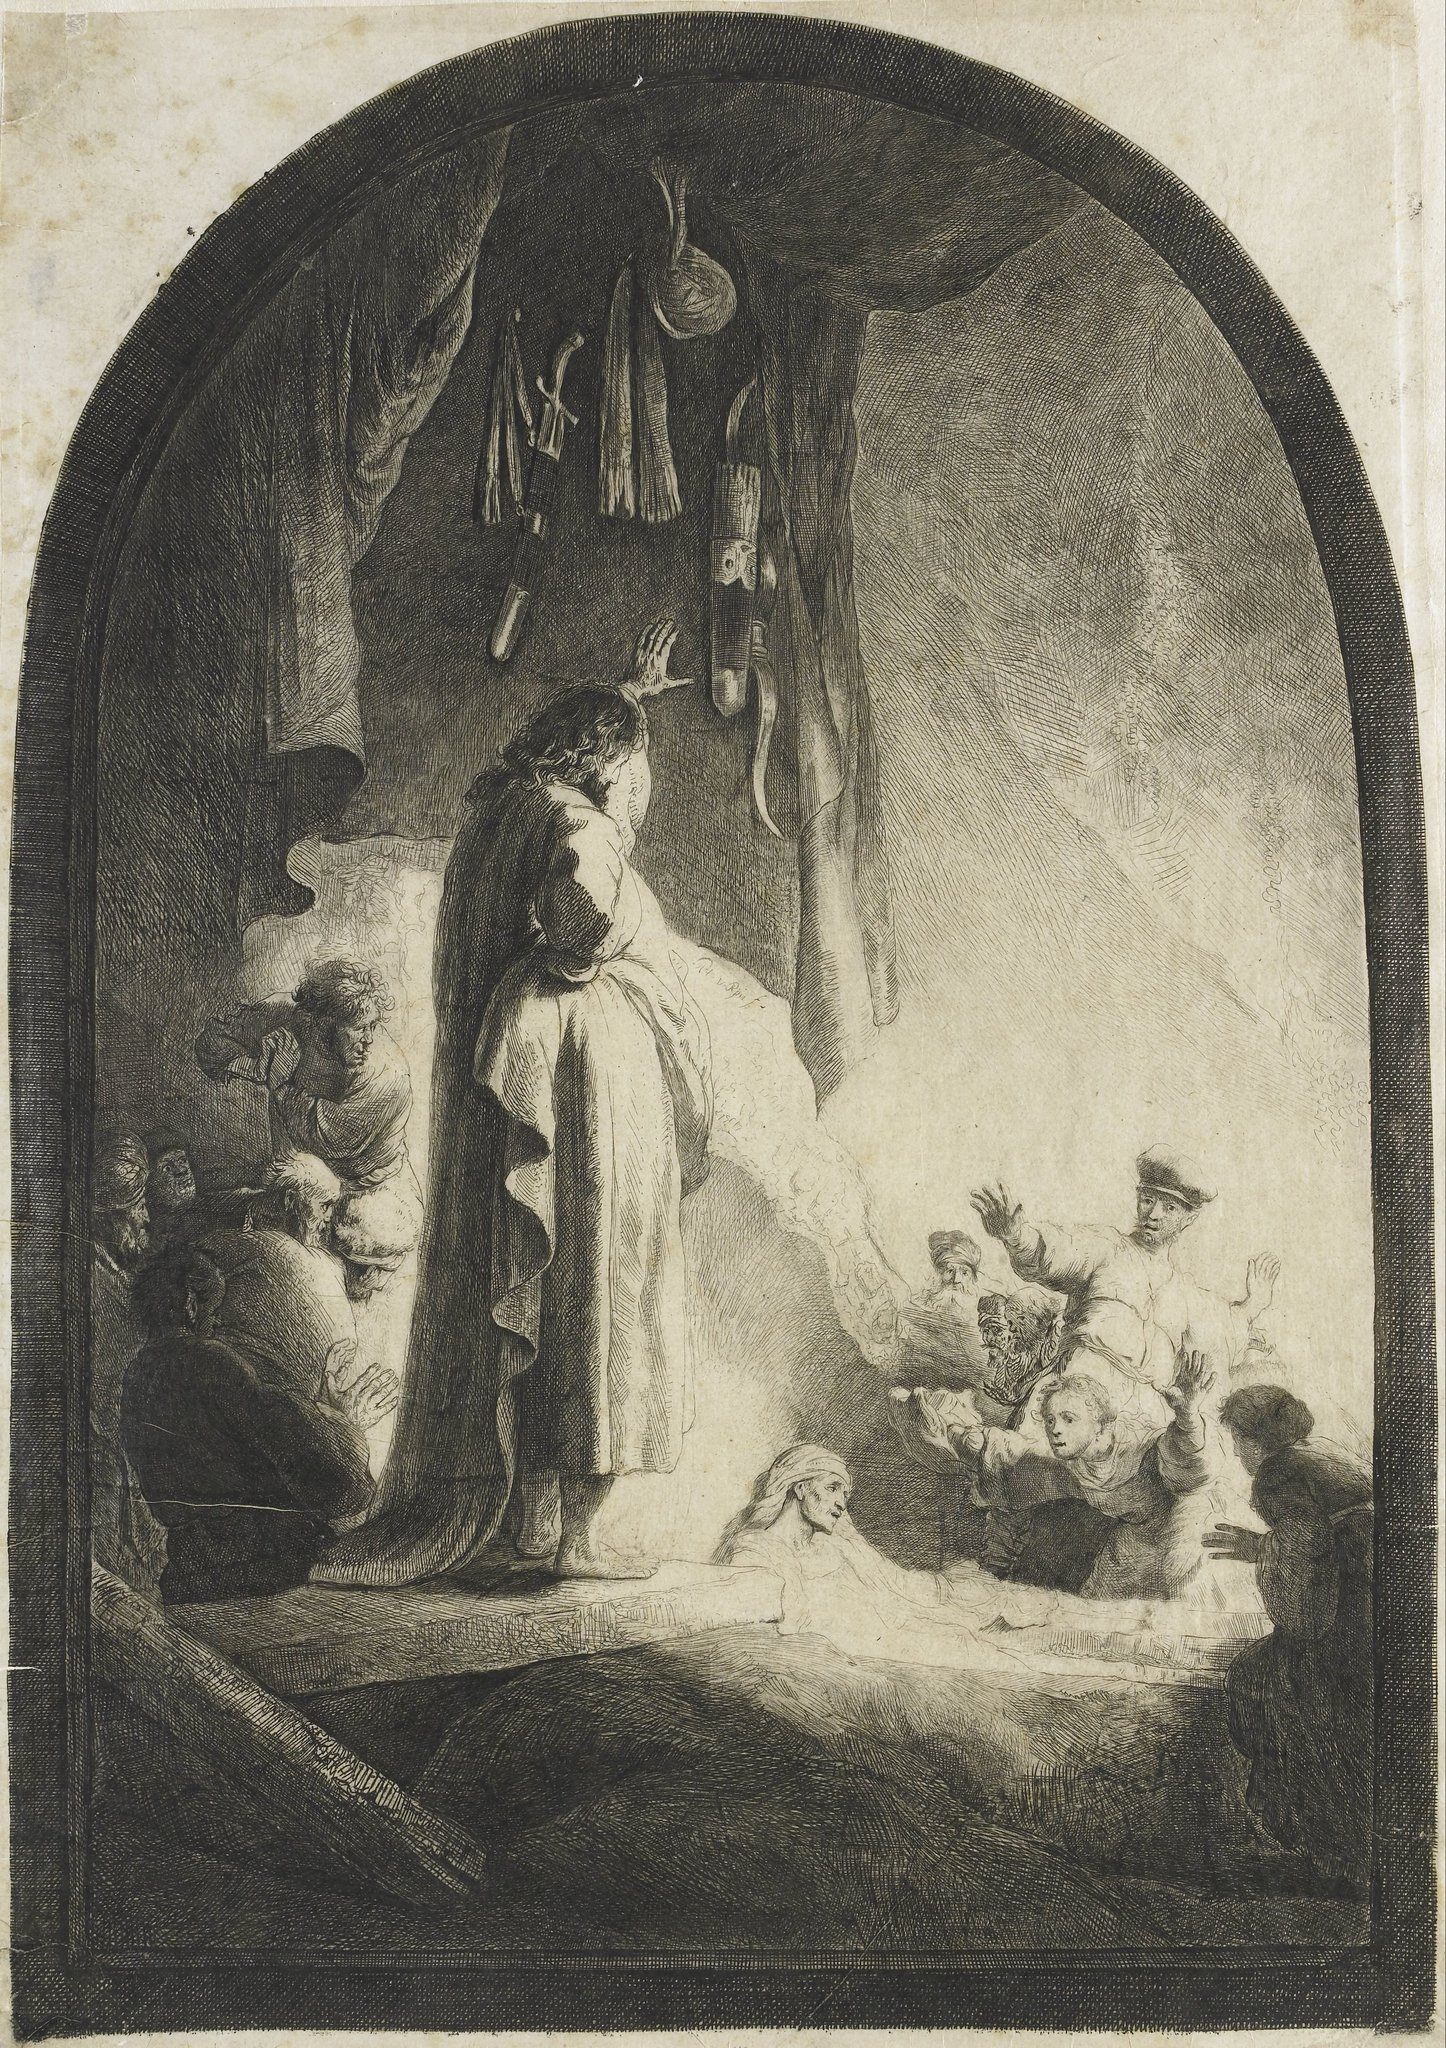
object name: print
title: The raising of Lazarus: the larger plate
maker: rembrandt van rijn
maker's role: draughtsman, painter, print maker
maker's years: 1606-1669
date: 1632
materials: paper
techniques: etching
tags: the raising of lazarus ('lazarus, come out')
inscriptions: mark: Lugt 2228 a, signature: ‘RHL. v Rijn f.’, mark: Lugt 2763